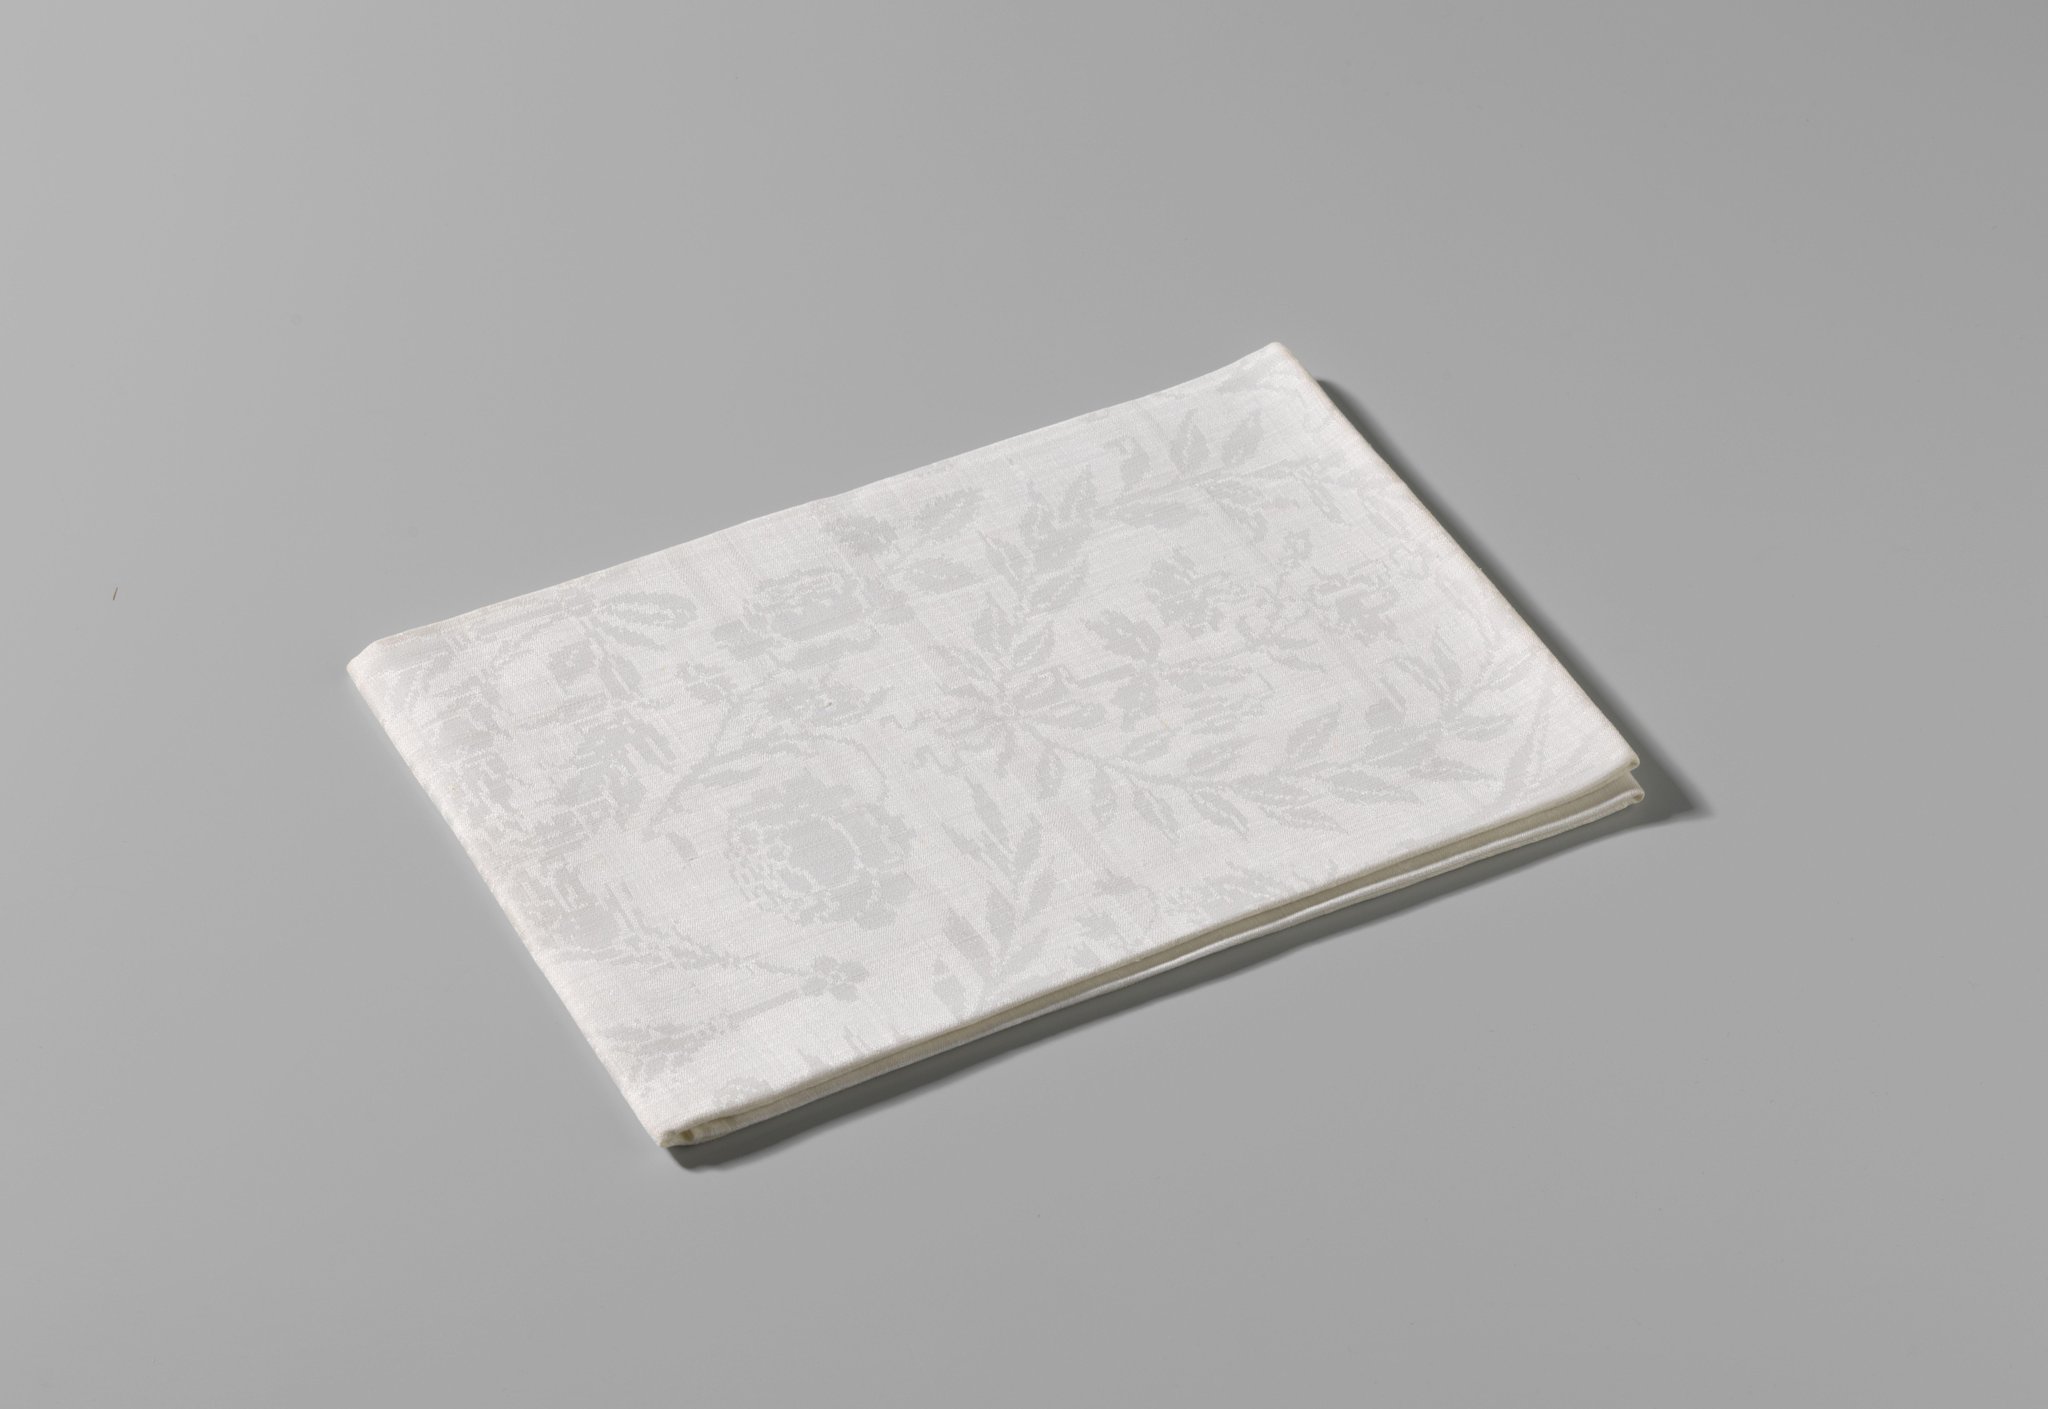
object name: napkin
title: Servet met een bloempatroon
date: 1655-1665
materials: linen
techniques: damask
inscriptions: mark: ‘DAVA 18’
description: Servet van linnendamast met guirlandes, bloemen in gestrikte kransen, gestrikte boeketten en strooibloemen. Randen met druivenranken; in de hoeken een druiventros aan bebladerde steel.